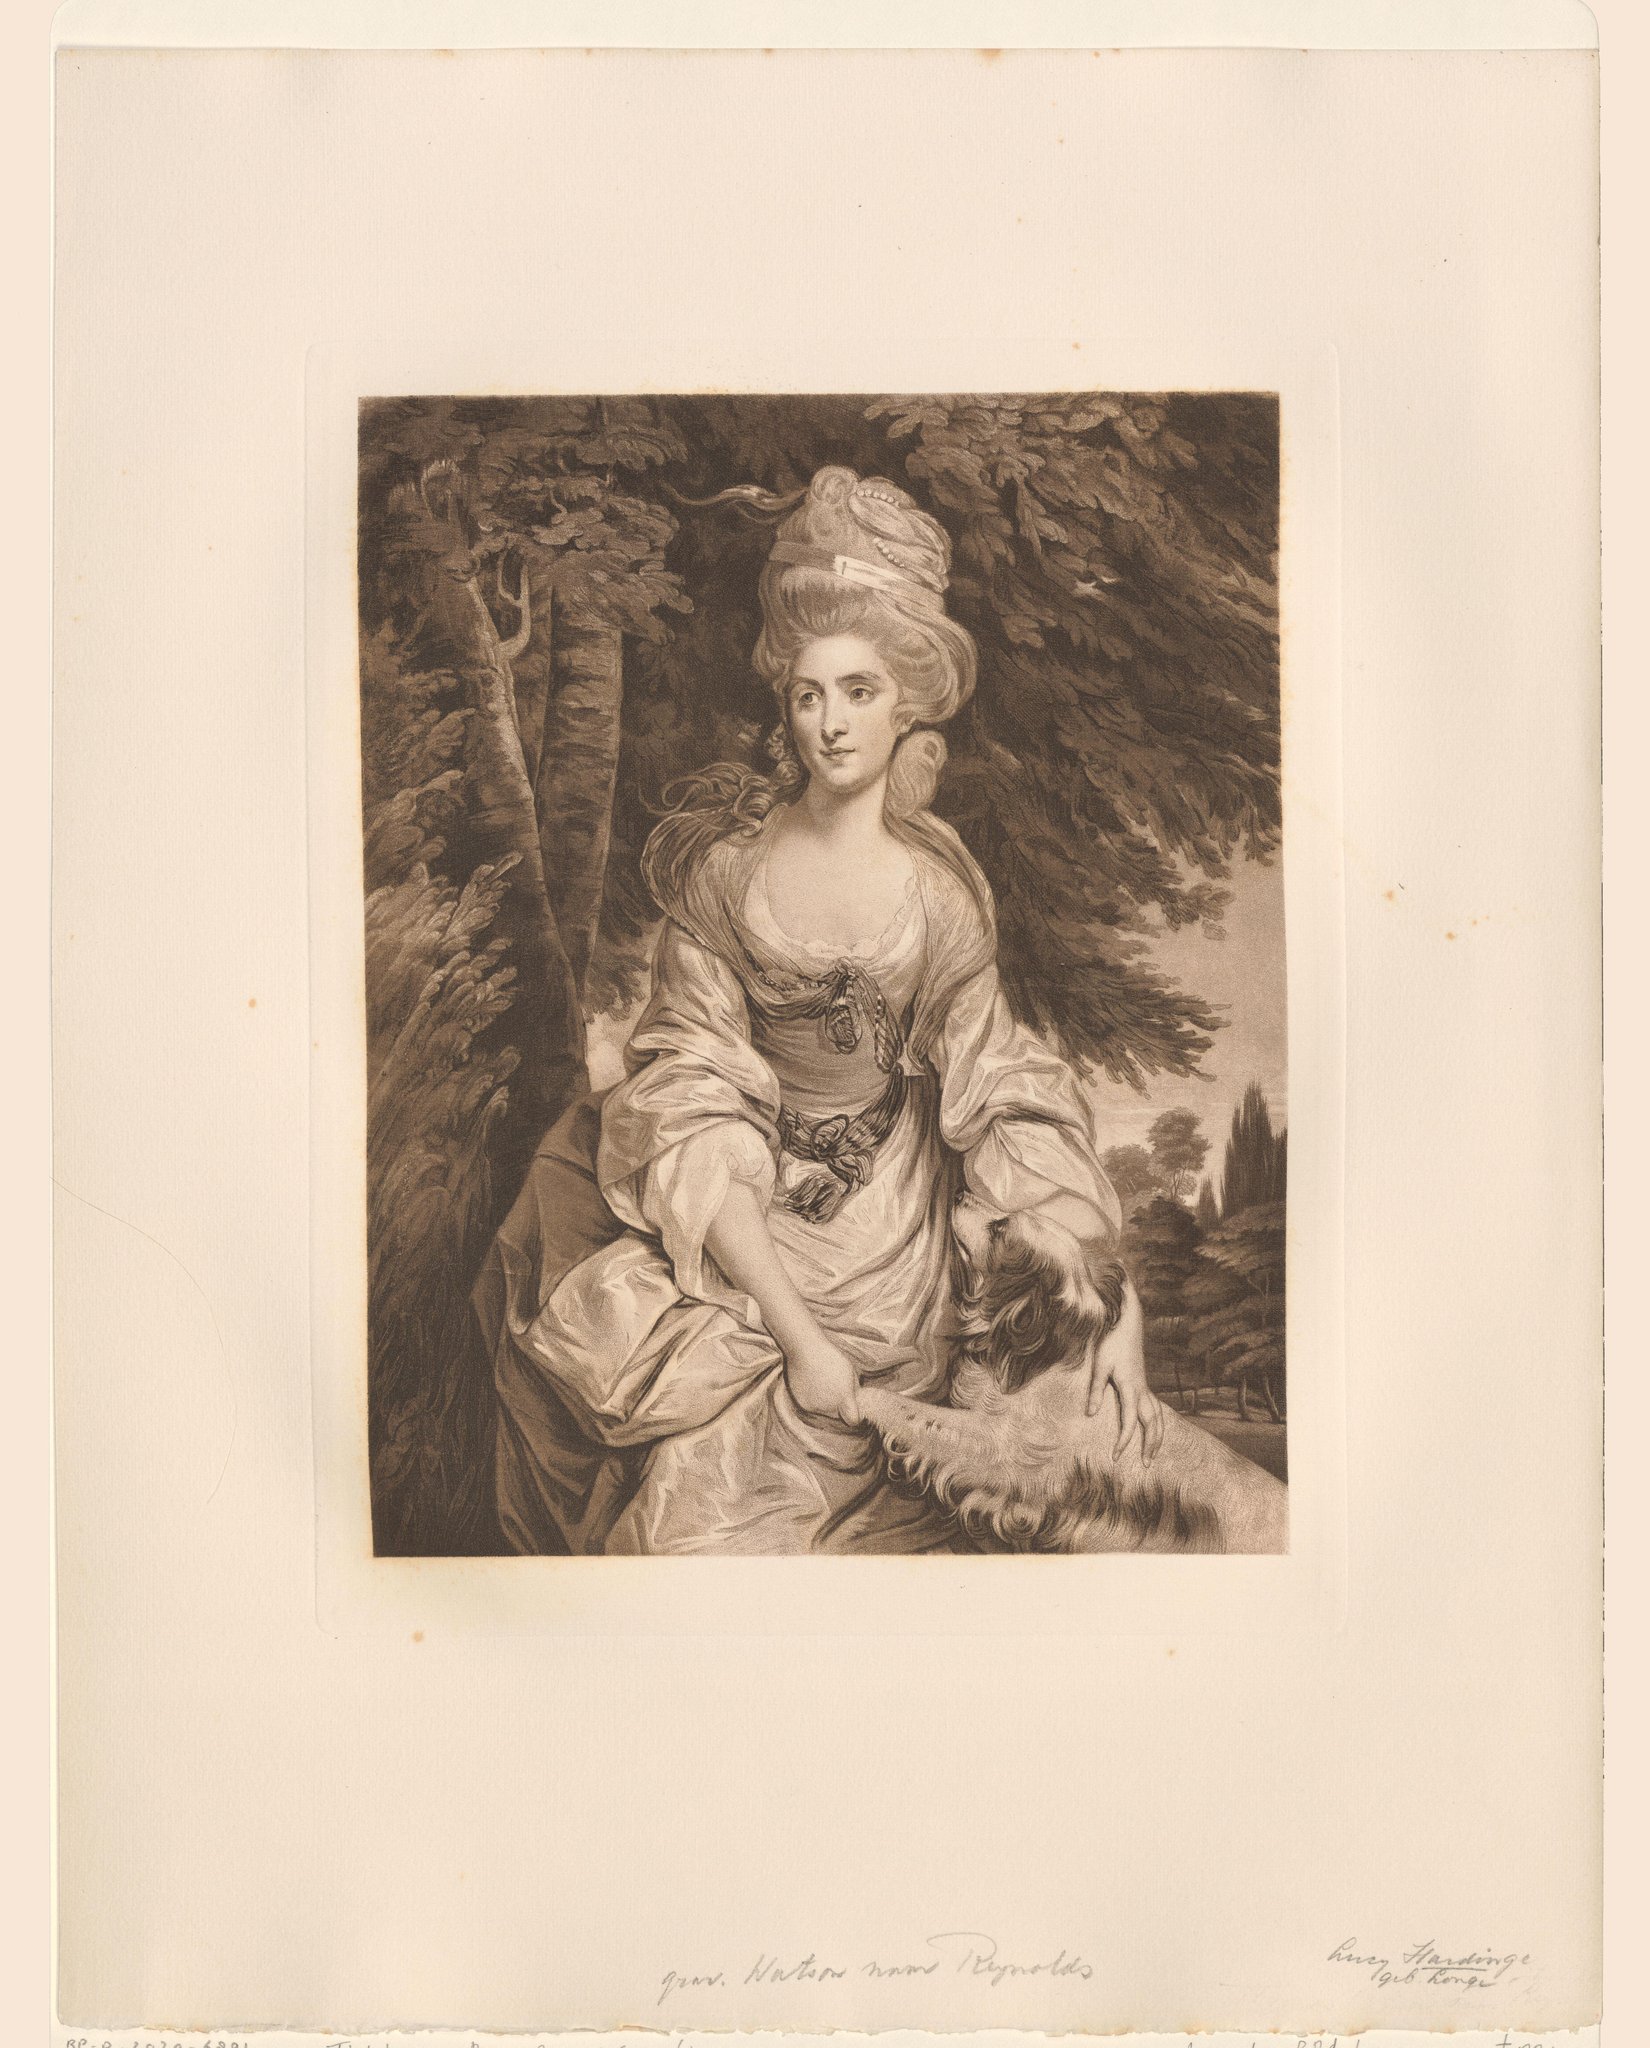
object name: photomechanical print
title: Portret van Lucy Hardinge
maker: Anonymous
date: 1870-1915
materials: paper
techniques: photoaquatint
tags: historical persons - bb - woman, dog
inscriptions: collector's mark: Lugt 2228